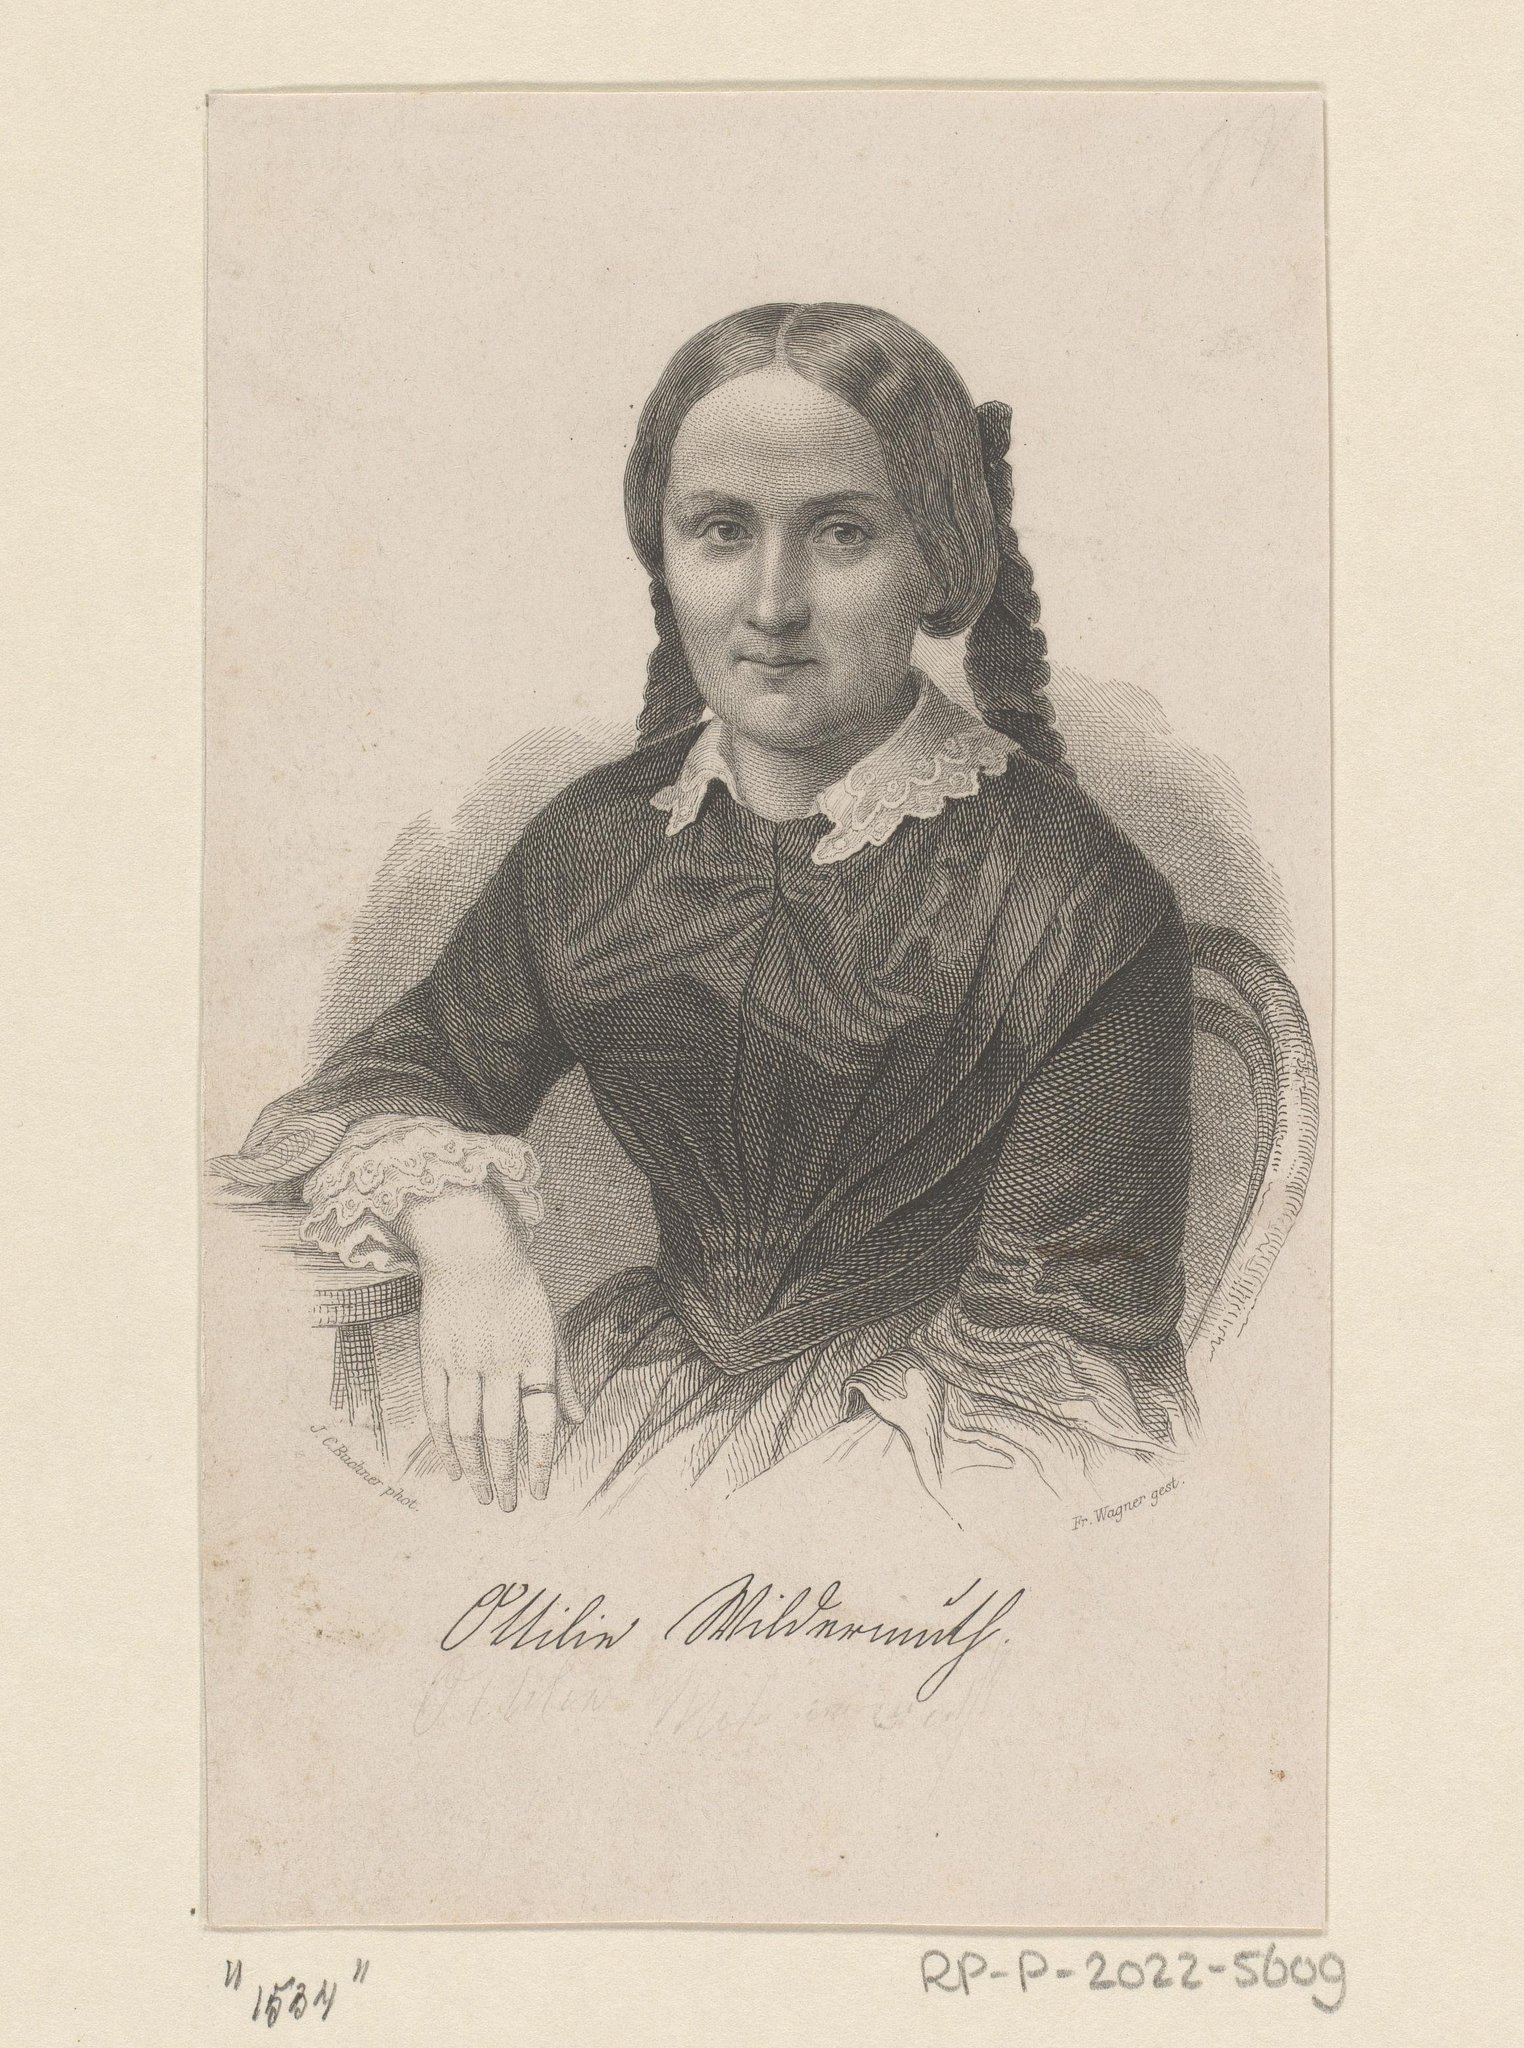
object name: print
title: Portret van Ottilie Wildermuth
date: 1837-1877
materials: paper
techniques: etching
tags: historical persons - bb - woman